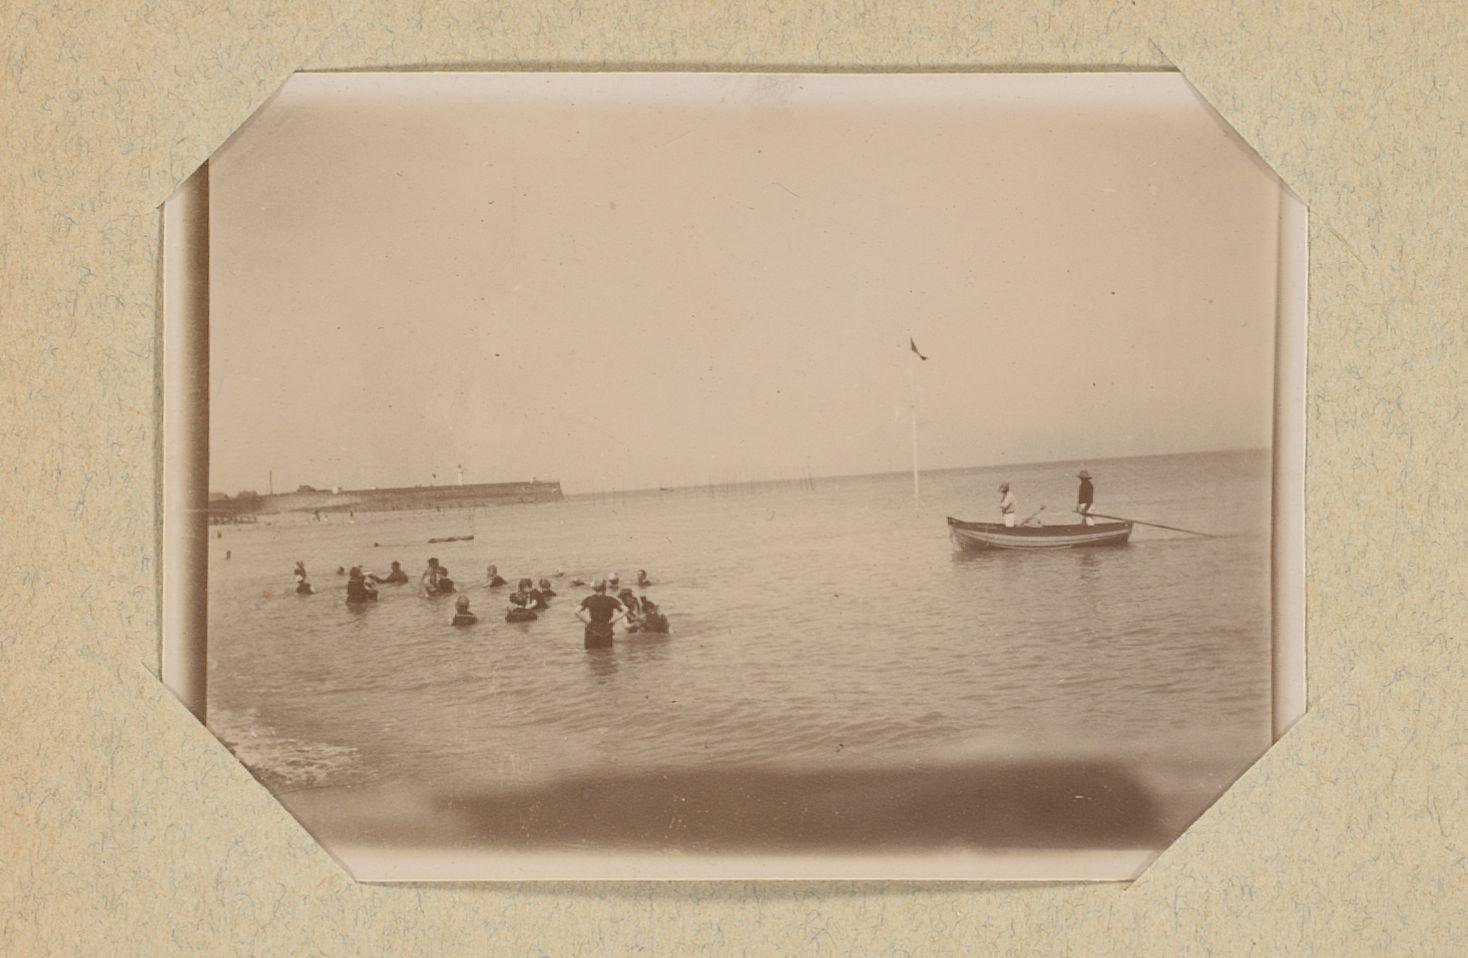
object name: album leaf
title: Zwemmende mensen in zee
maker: Anonymous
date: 1895-1900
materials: paper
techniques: gelatin silver print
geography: france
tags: swimming (movement in water), sea, france